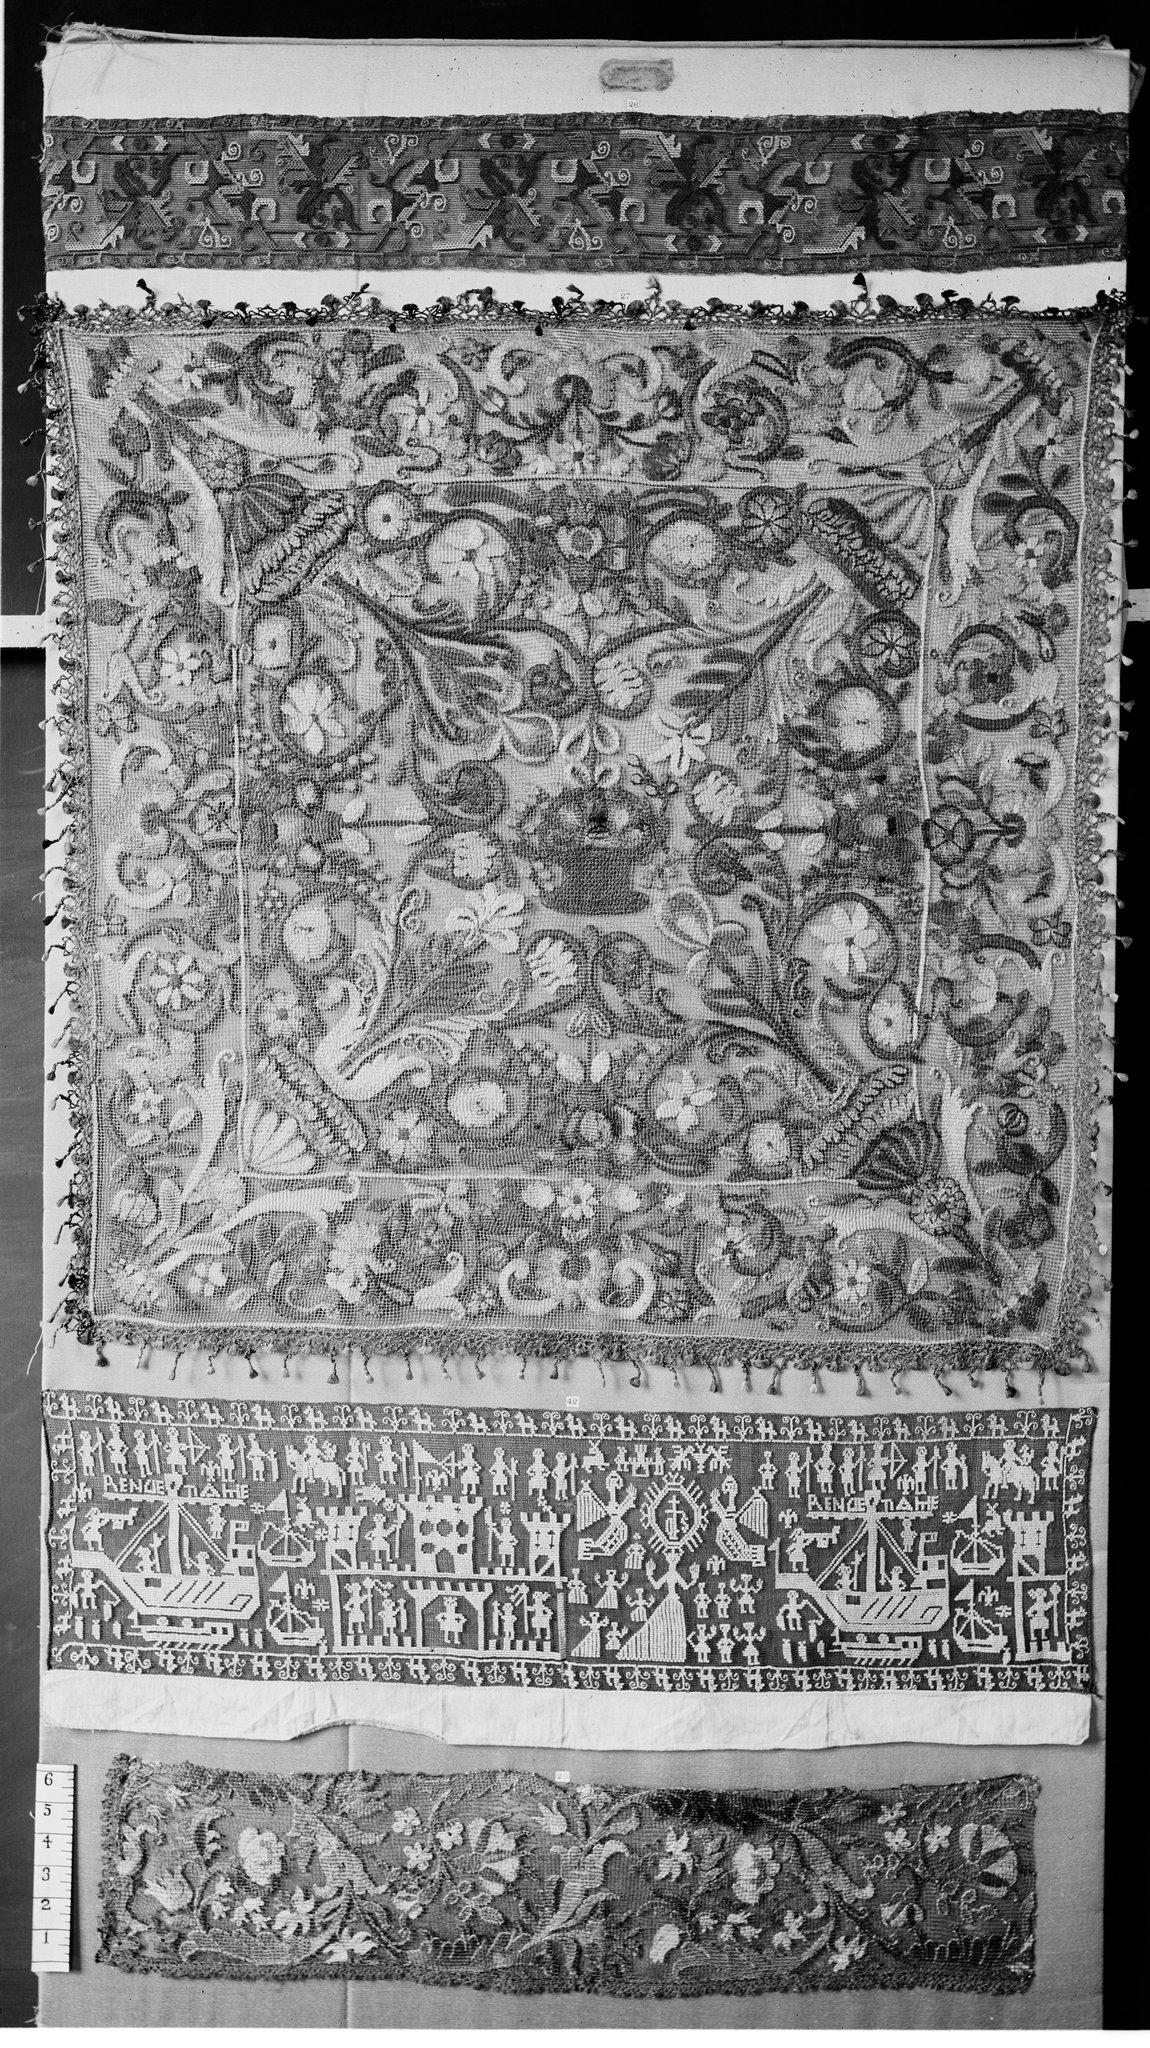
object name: cover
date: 1601-1633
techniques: embroidery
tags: horses,flowers,ships